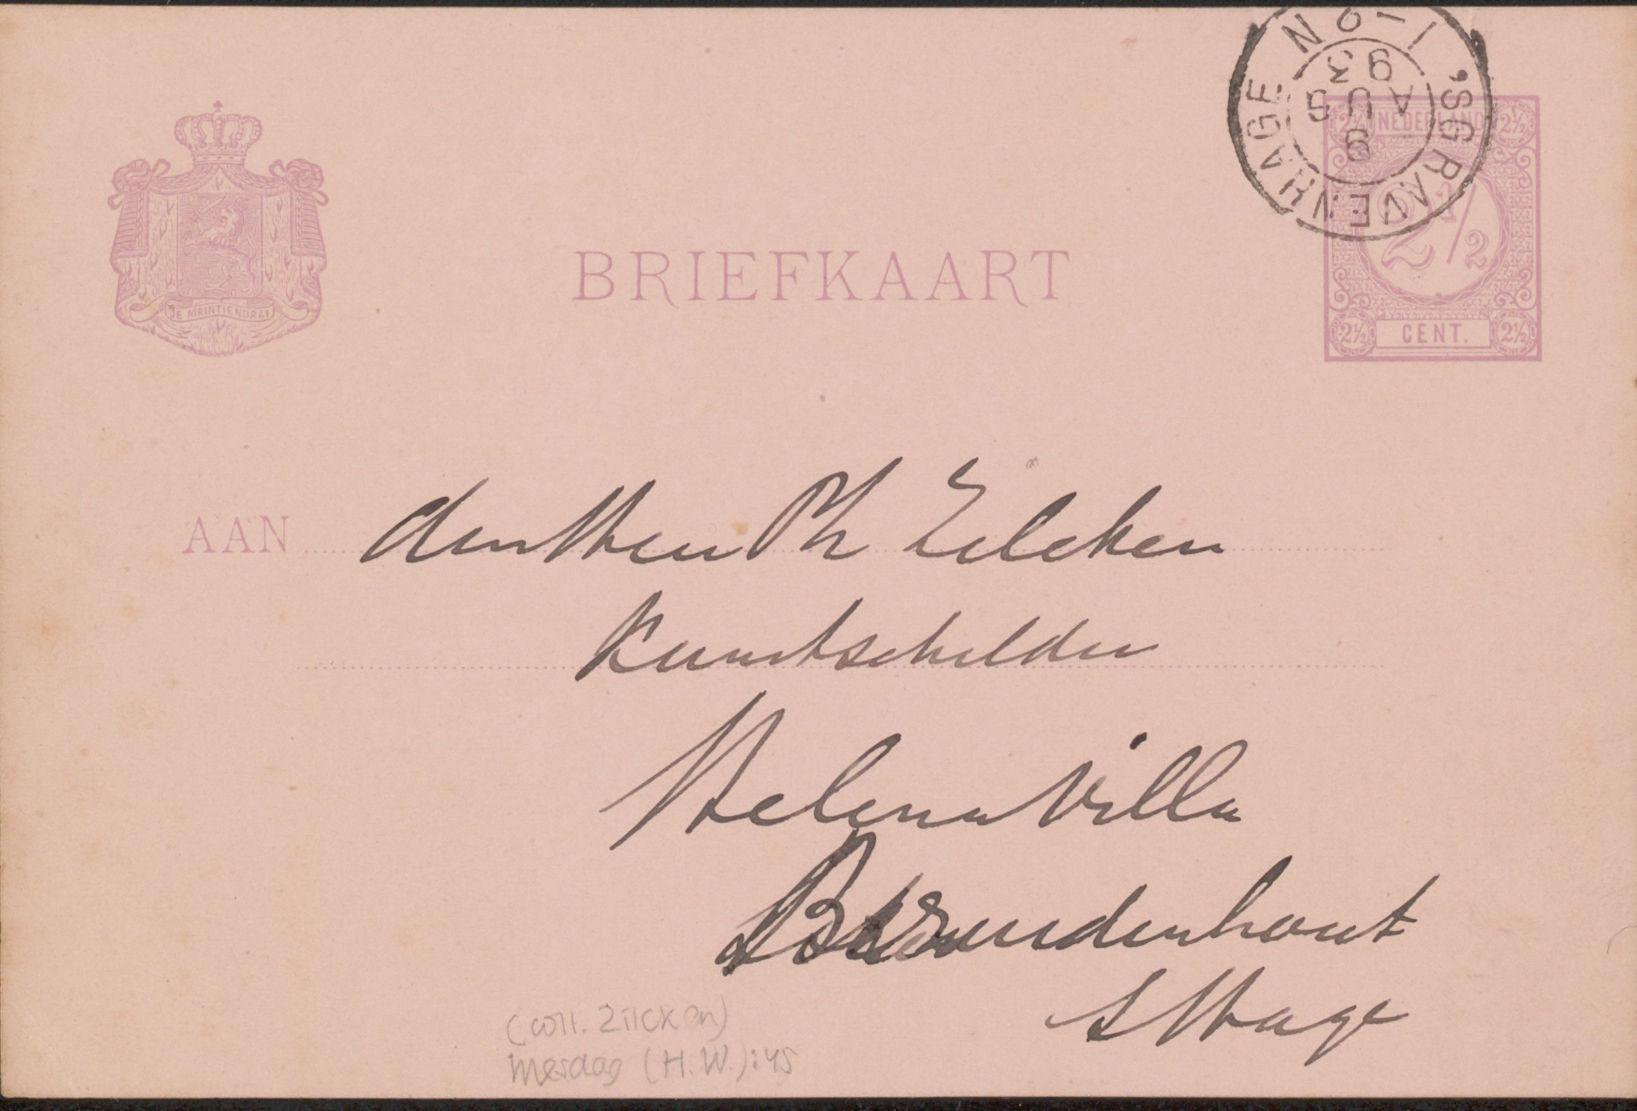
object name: postcard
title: Briefkaart aan Philip Zilcken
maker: hendrik willem mesdag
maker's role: draughtsman, painter, print maker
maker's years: 1831-1915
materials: cardboard, ink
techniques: pen, writing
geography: the hague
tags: klaas groesbeek, philip zilcken